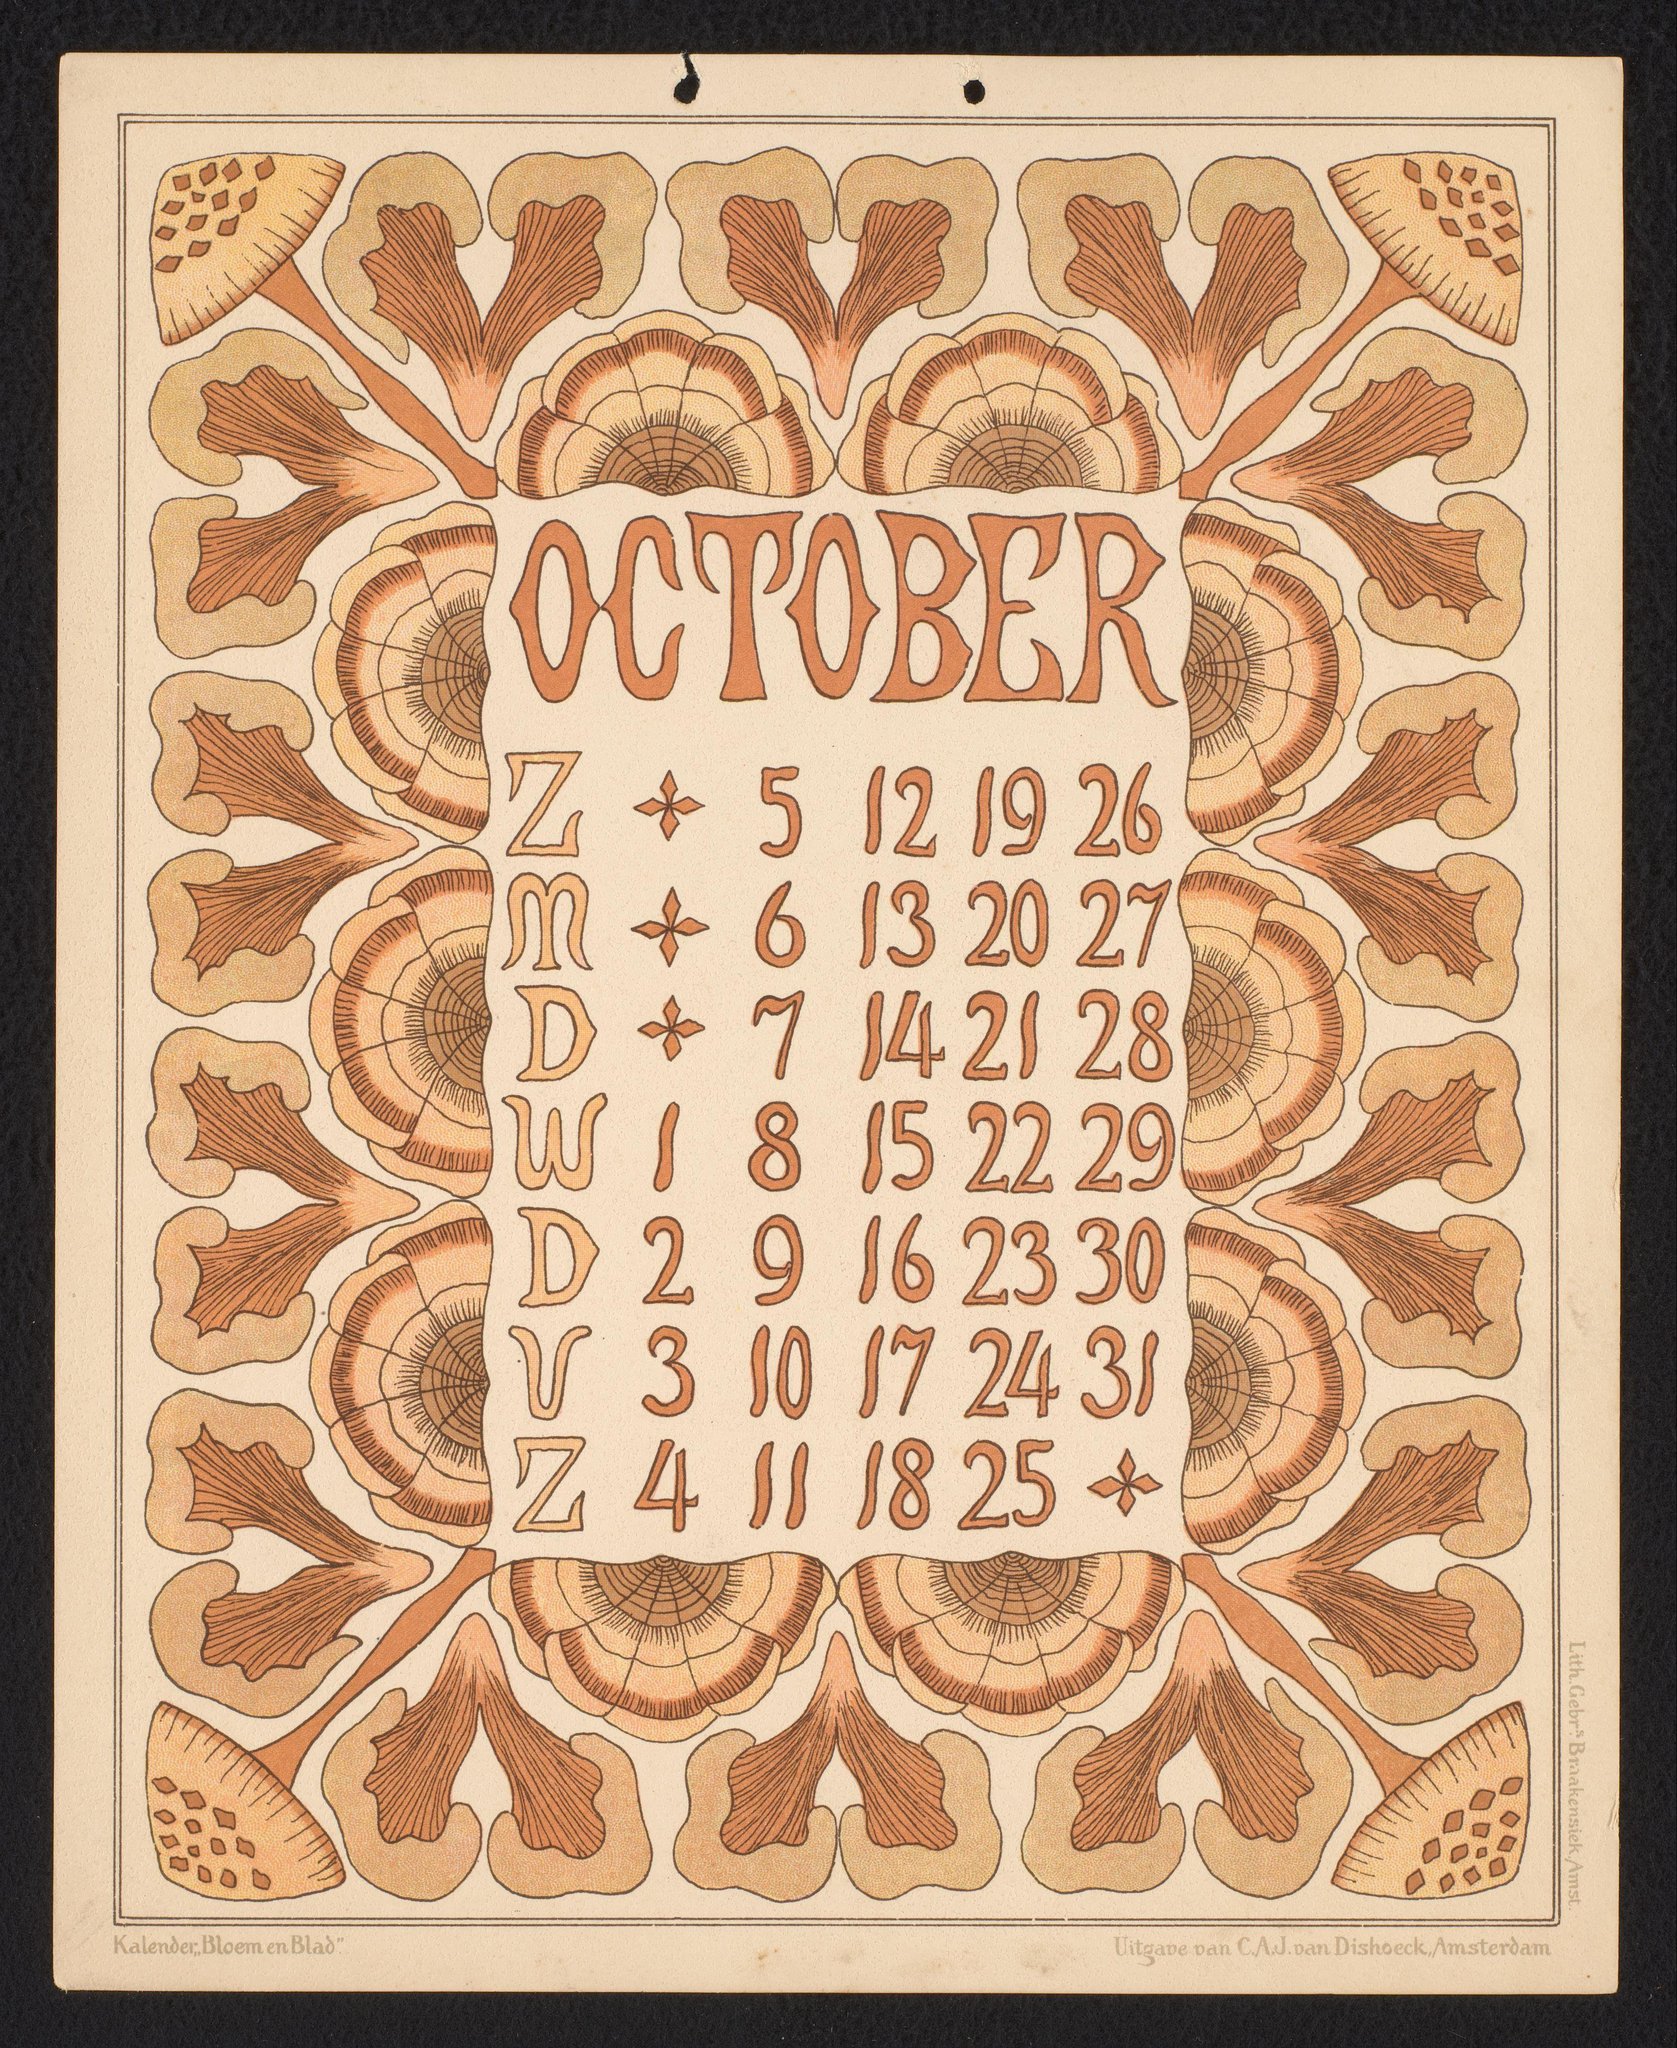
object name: calendar leaf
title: Kalenderblad voor oktober 1902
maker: c.a.j. van dishoeck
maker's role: publisher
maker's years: 1863-1931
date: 1901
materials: paper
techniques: lithograph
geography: amsterdam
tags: ornaments ~ art, calendar, almanac, mushrooms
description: Kalenderblad voor oktober 1902 van de kalender 'Bloem en Blad', met een randdecoratie van paddenstoelen.